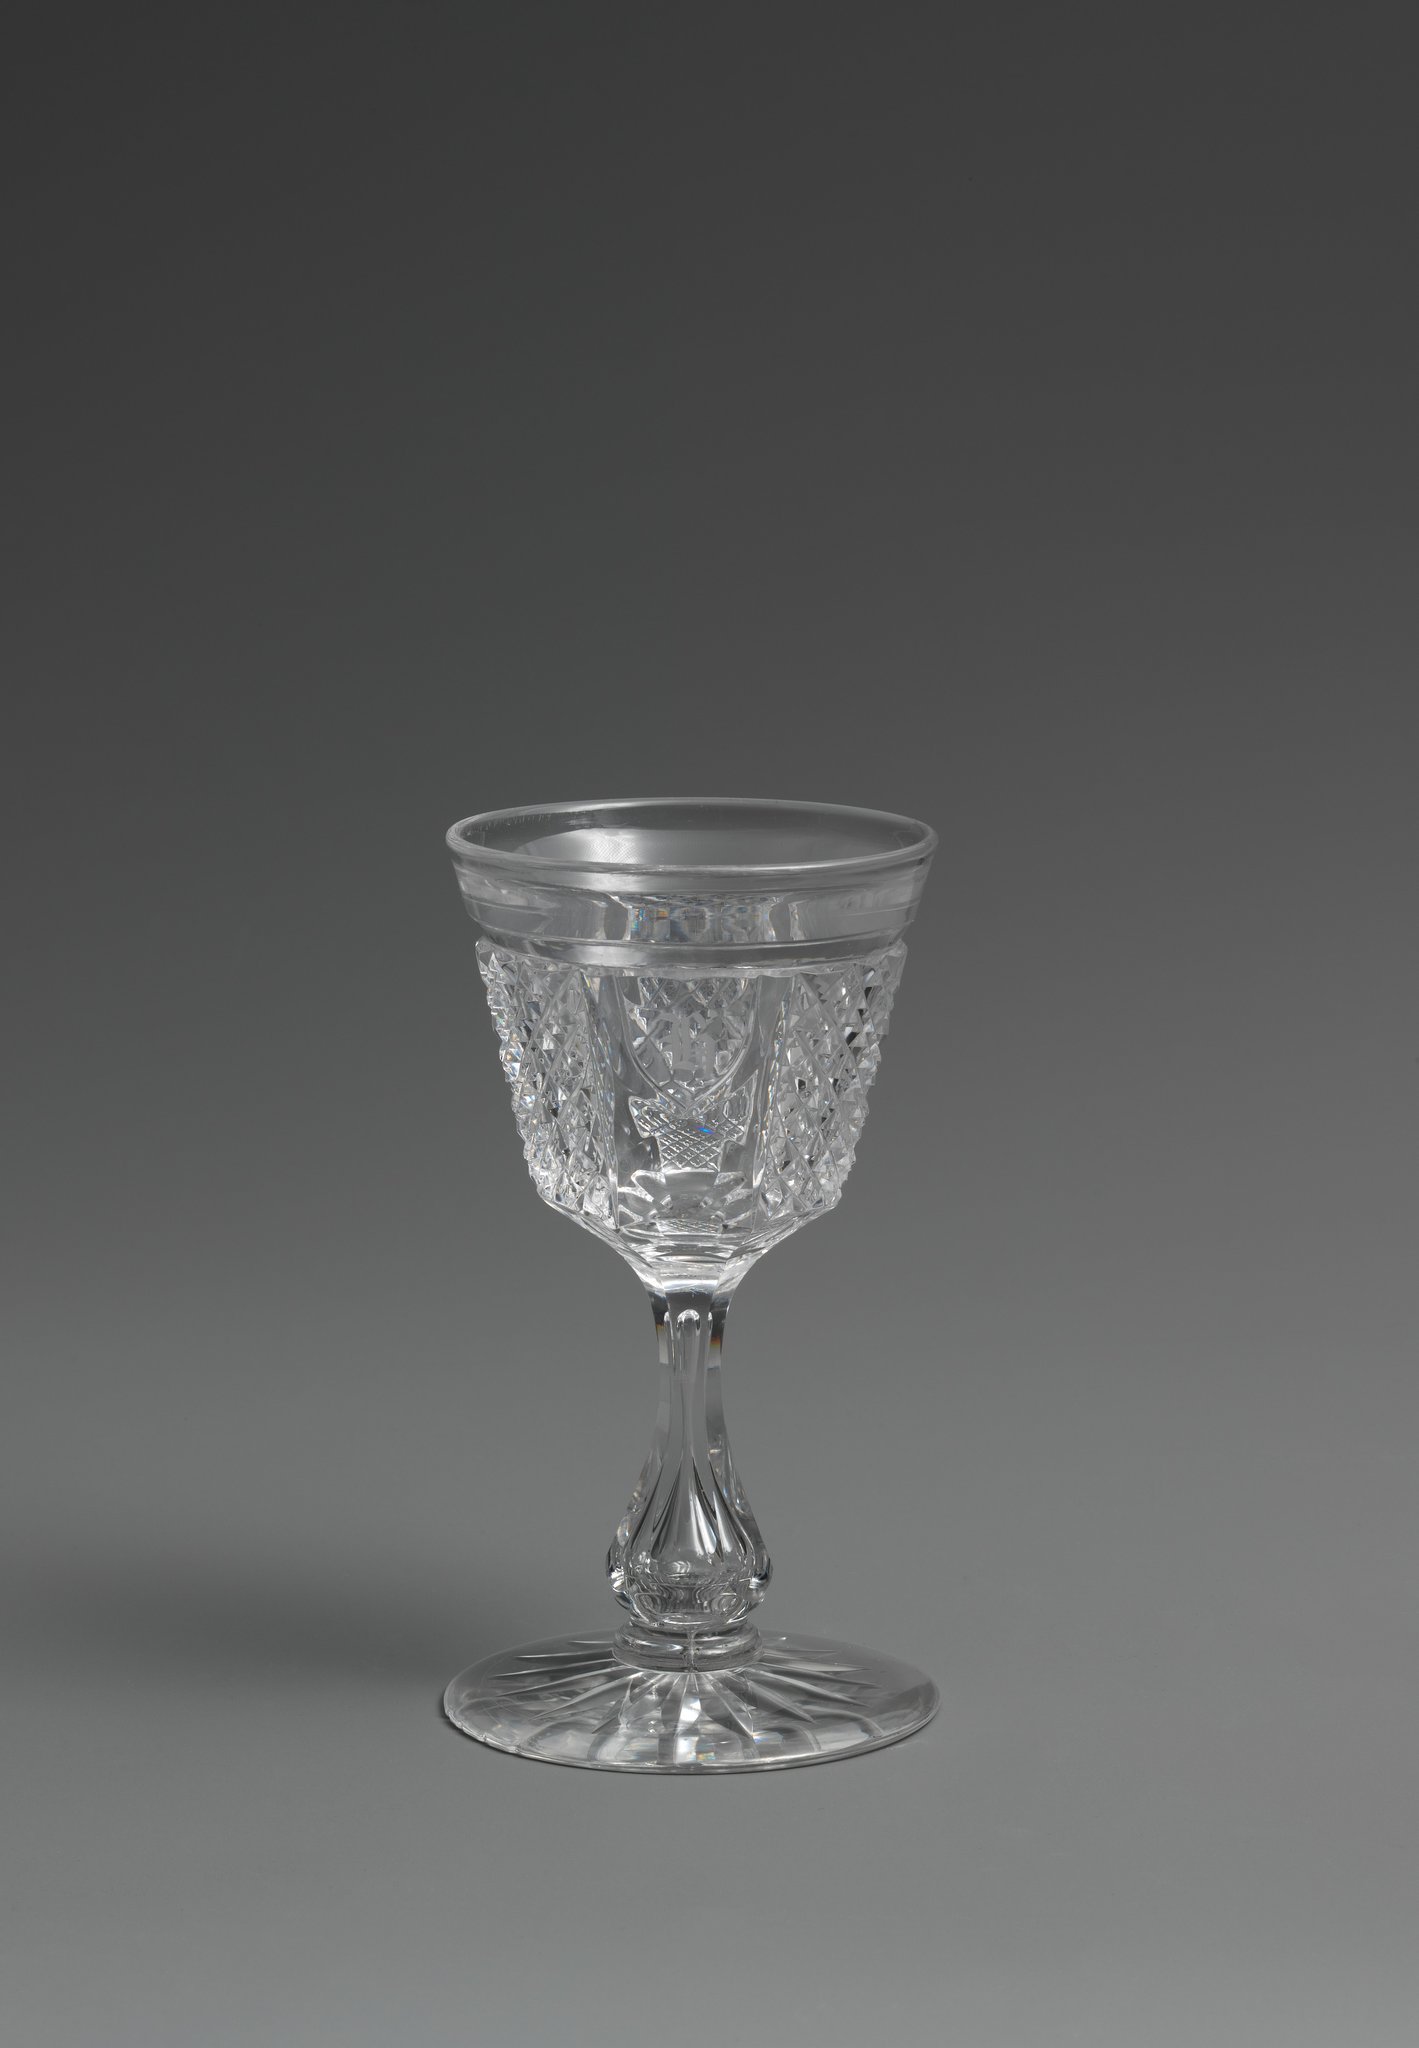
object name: drinking vessel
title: Small drinking vessel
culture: american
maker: brooklyn flint glass company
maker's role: manufacturer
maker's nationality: american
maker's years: 1824-1868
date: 1855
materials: glass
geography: united states